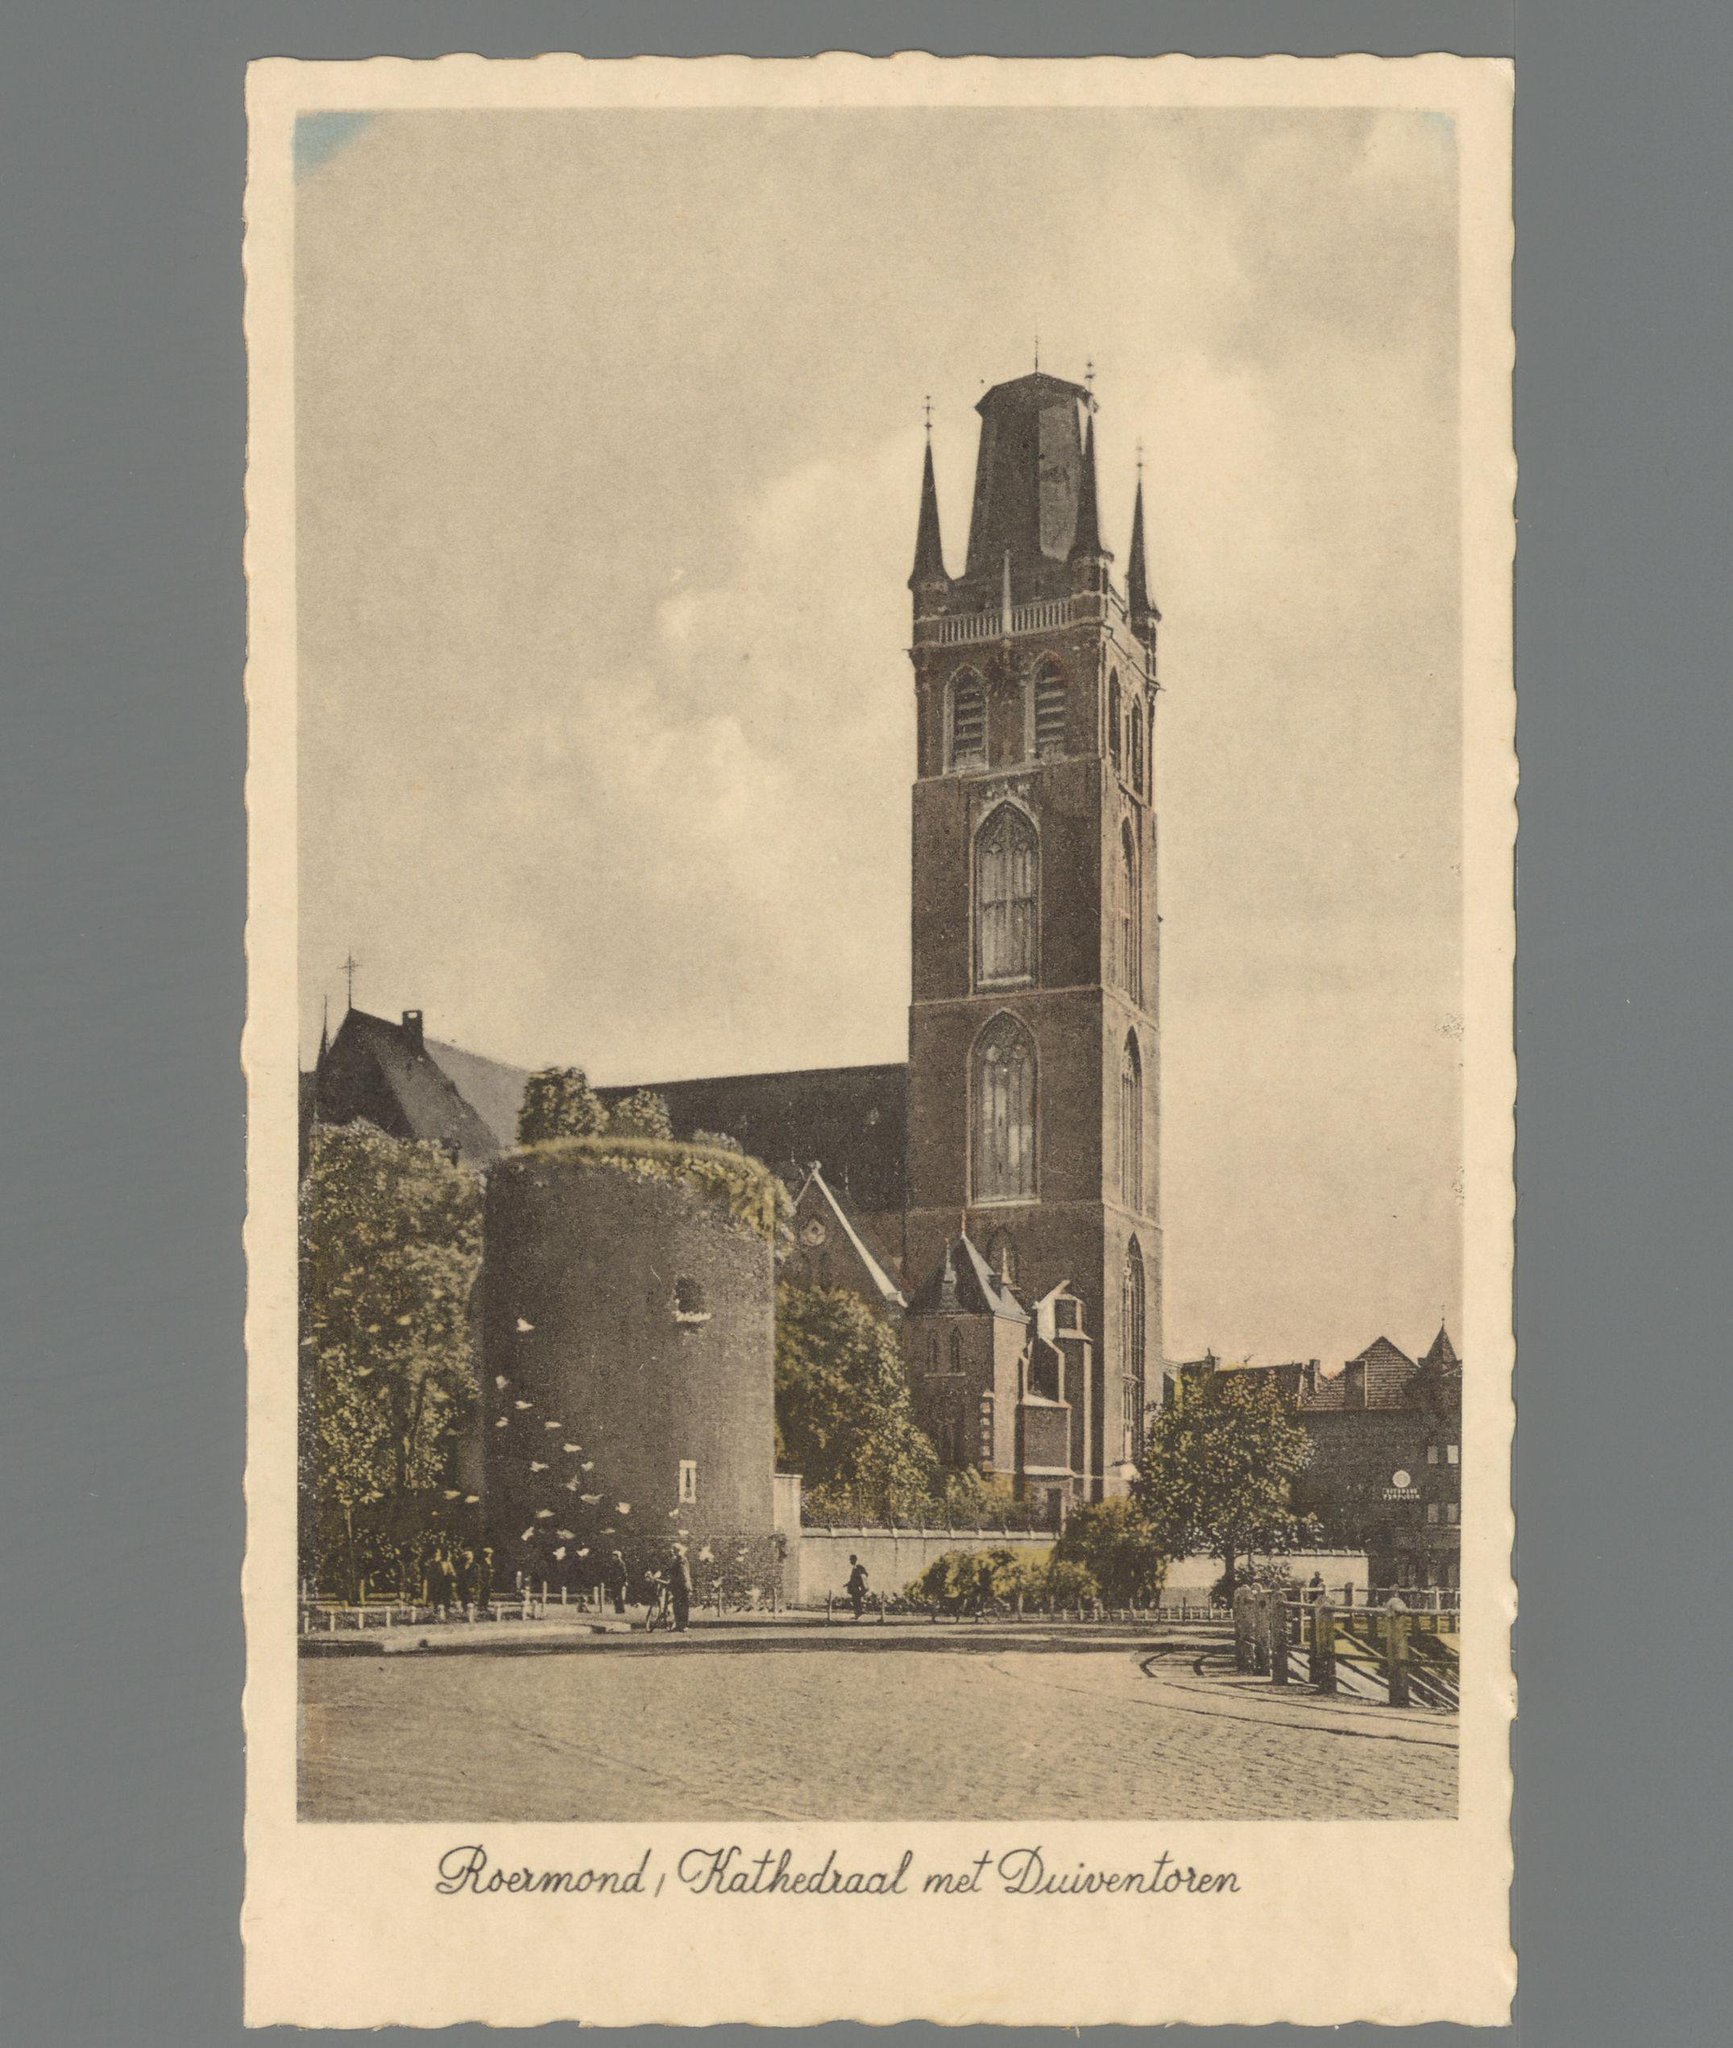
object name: ansichtkaart, prentbriefkaart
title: Roermond, kathedraaal met duiventoren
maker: Anonymous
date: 1913-1950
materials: cardboard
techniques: photograph, hand coloring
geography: roermond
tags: towers ~ fortified city, church (exterior)